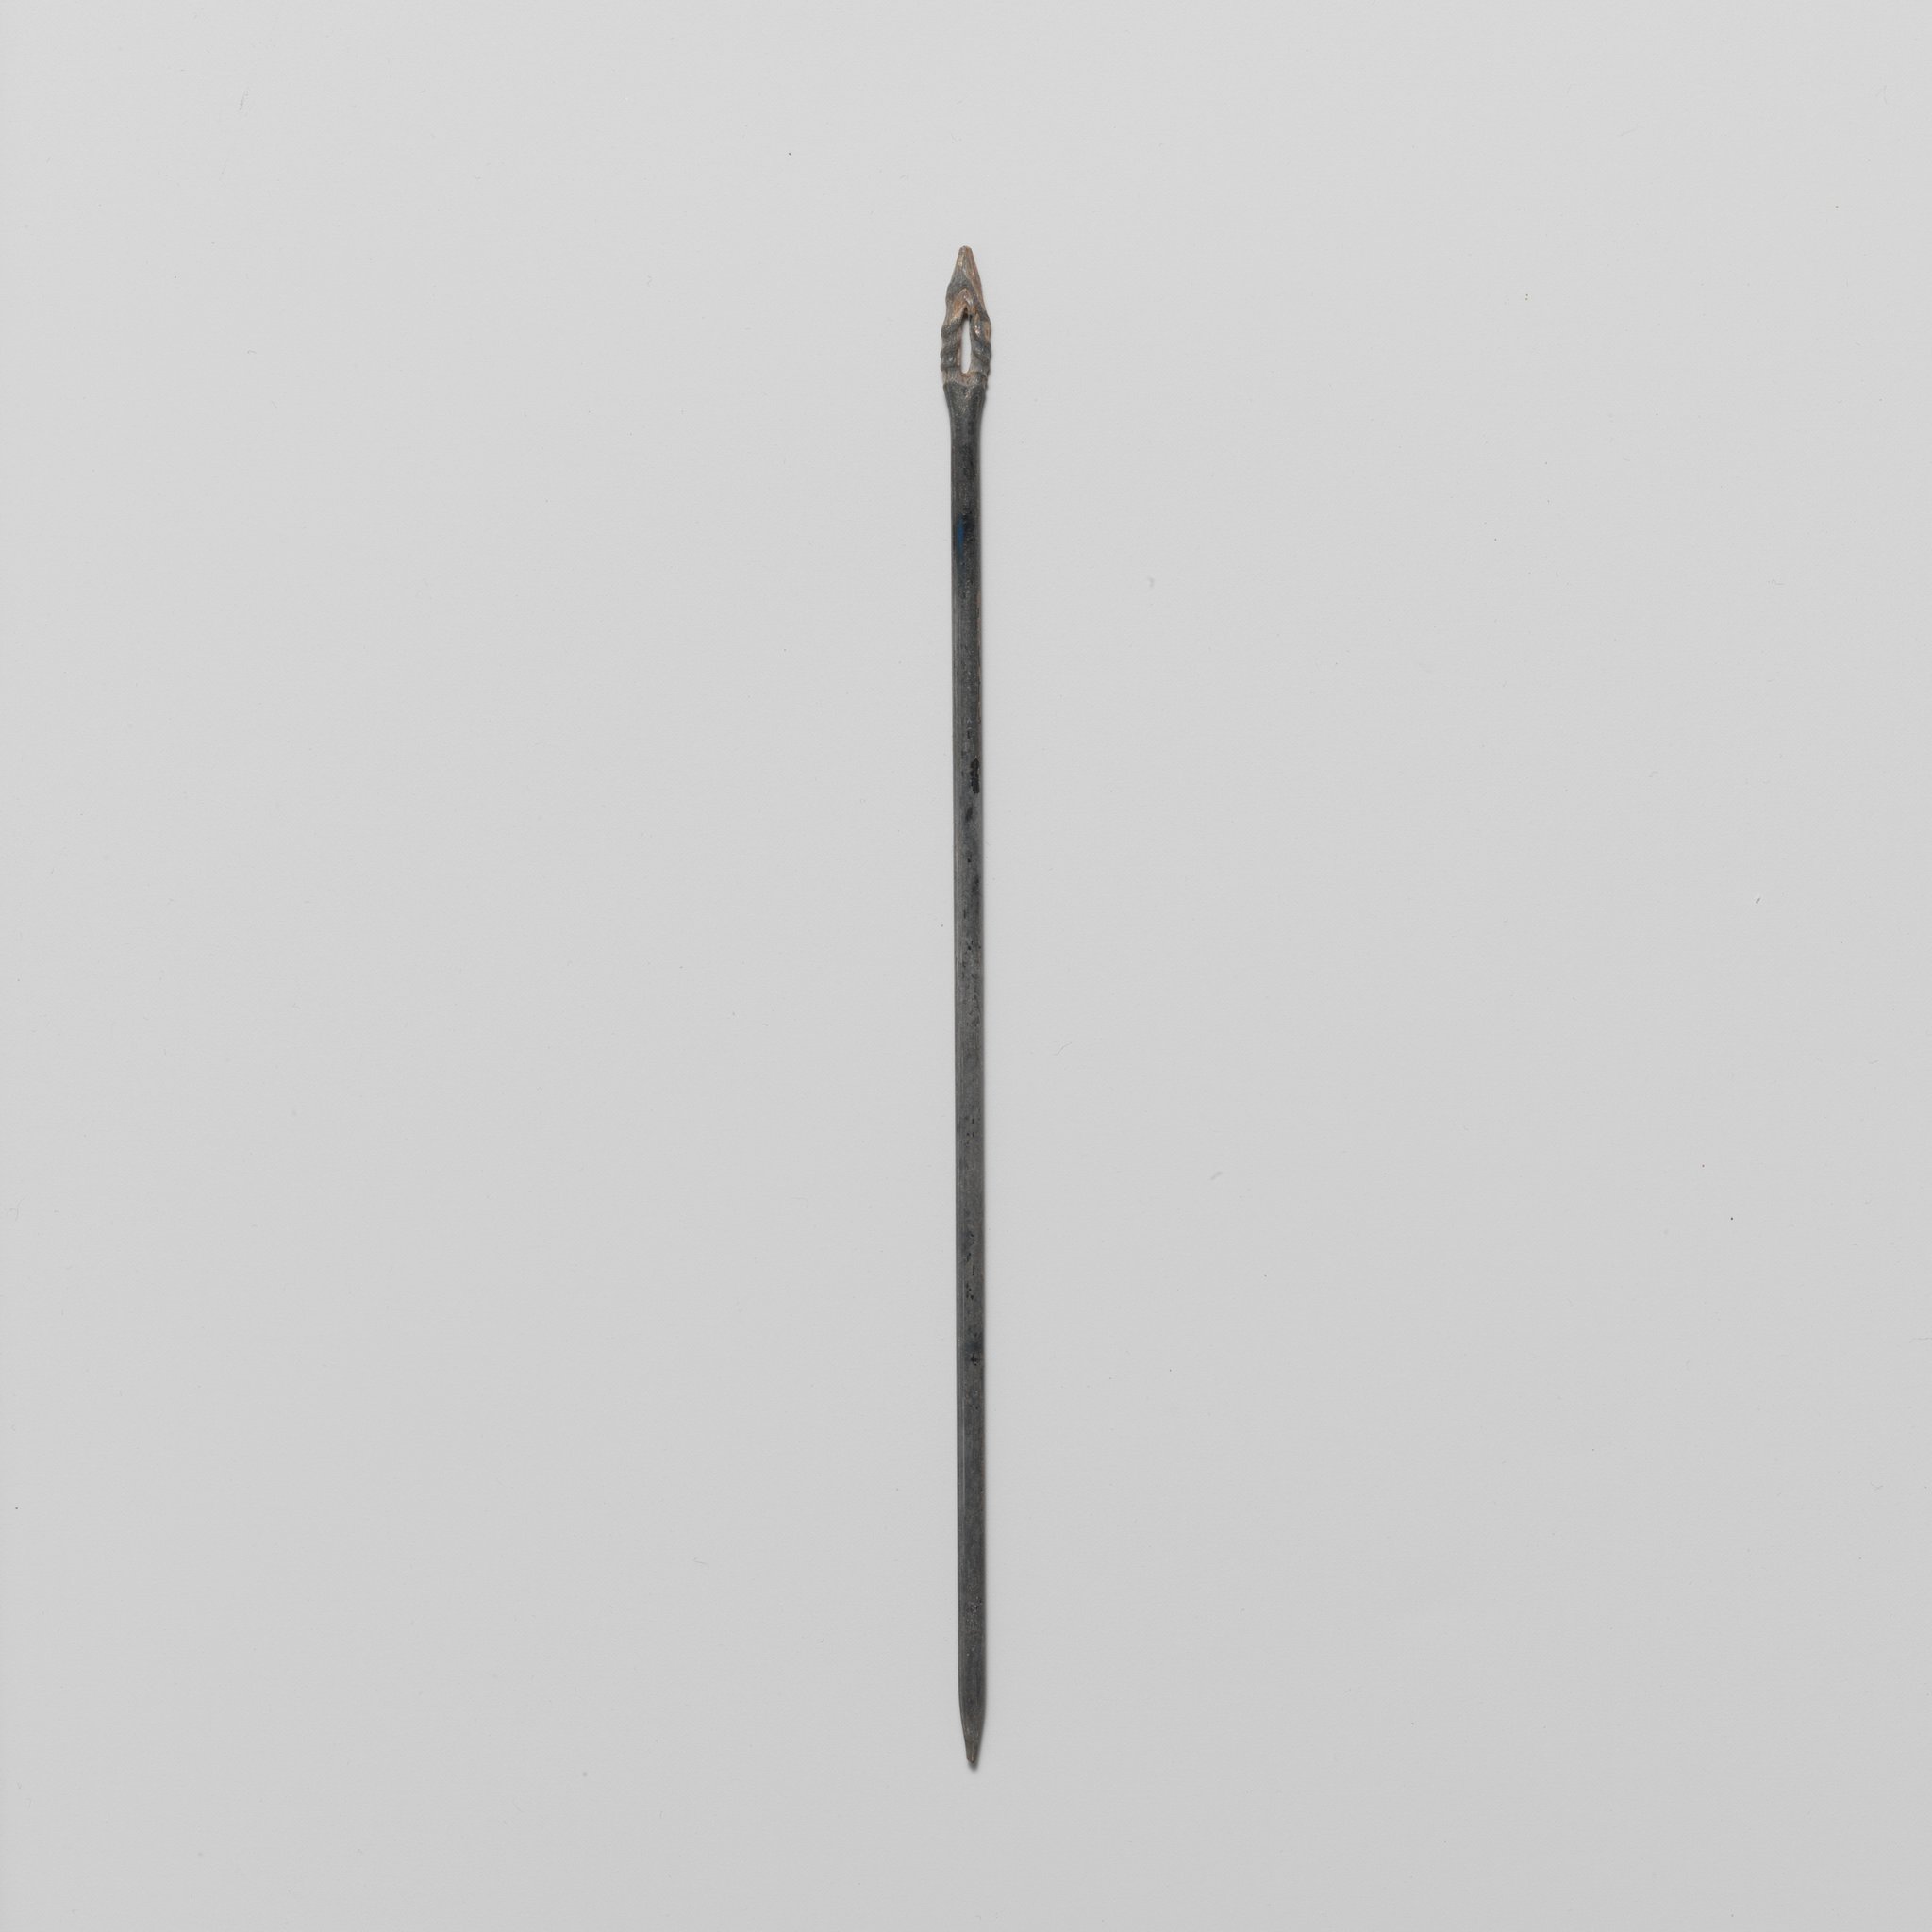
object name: needle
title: Glass needle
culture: roman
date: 1-100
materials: glass